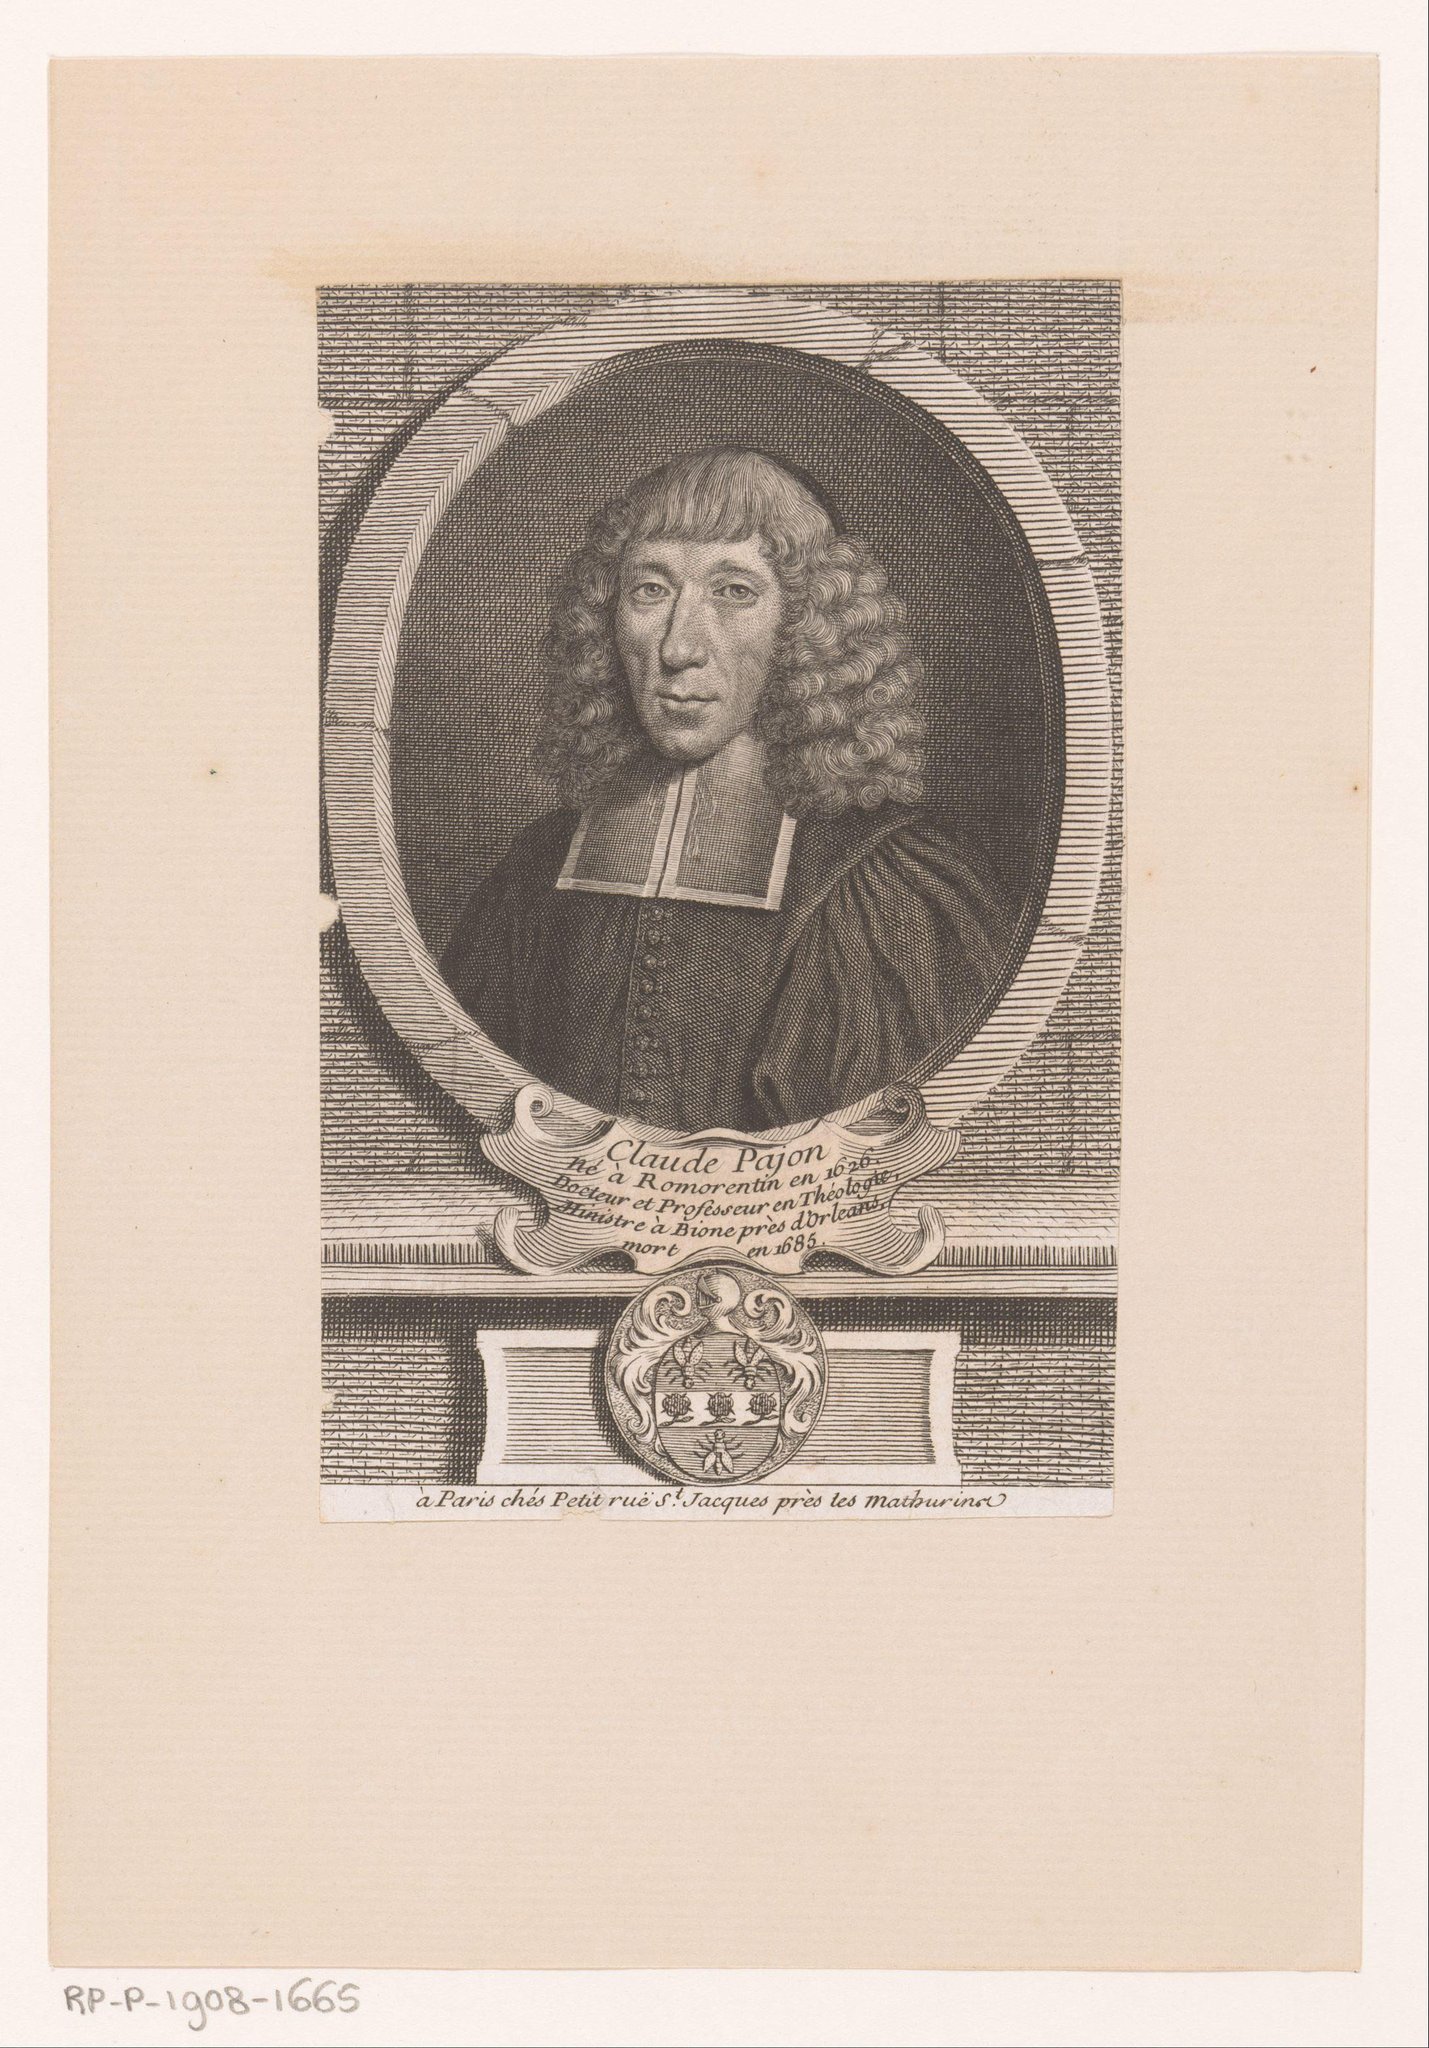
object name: print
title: Portret van Claude Pajon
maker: gille edme petit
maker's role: print maker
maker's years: 1694-1760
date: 1704-1760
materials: paper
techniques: engraving, etching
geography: paris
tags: theologian, historical persons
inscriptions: collector's mark: Lugt 2228